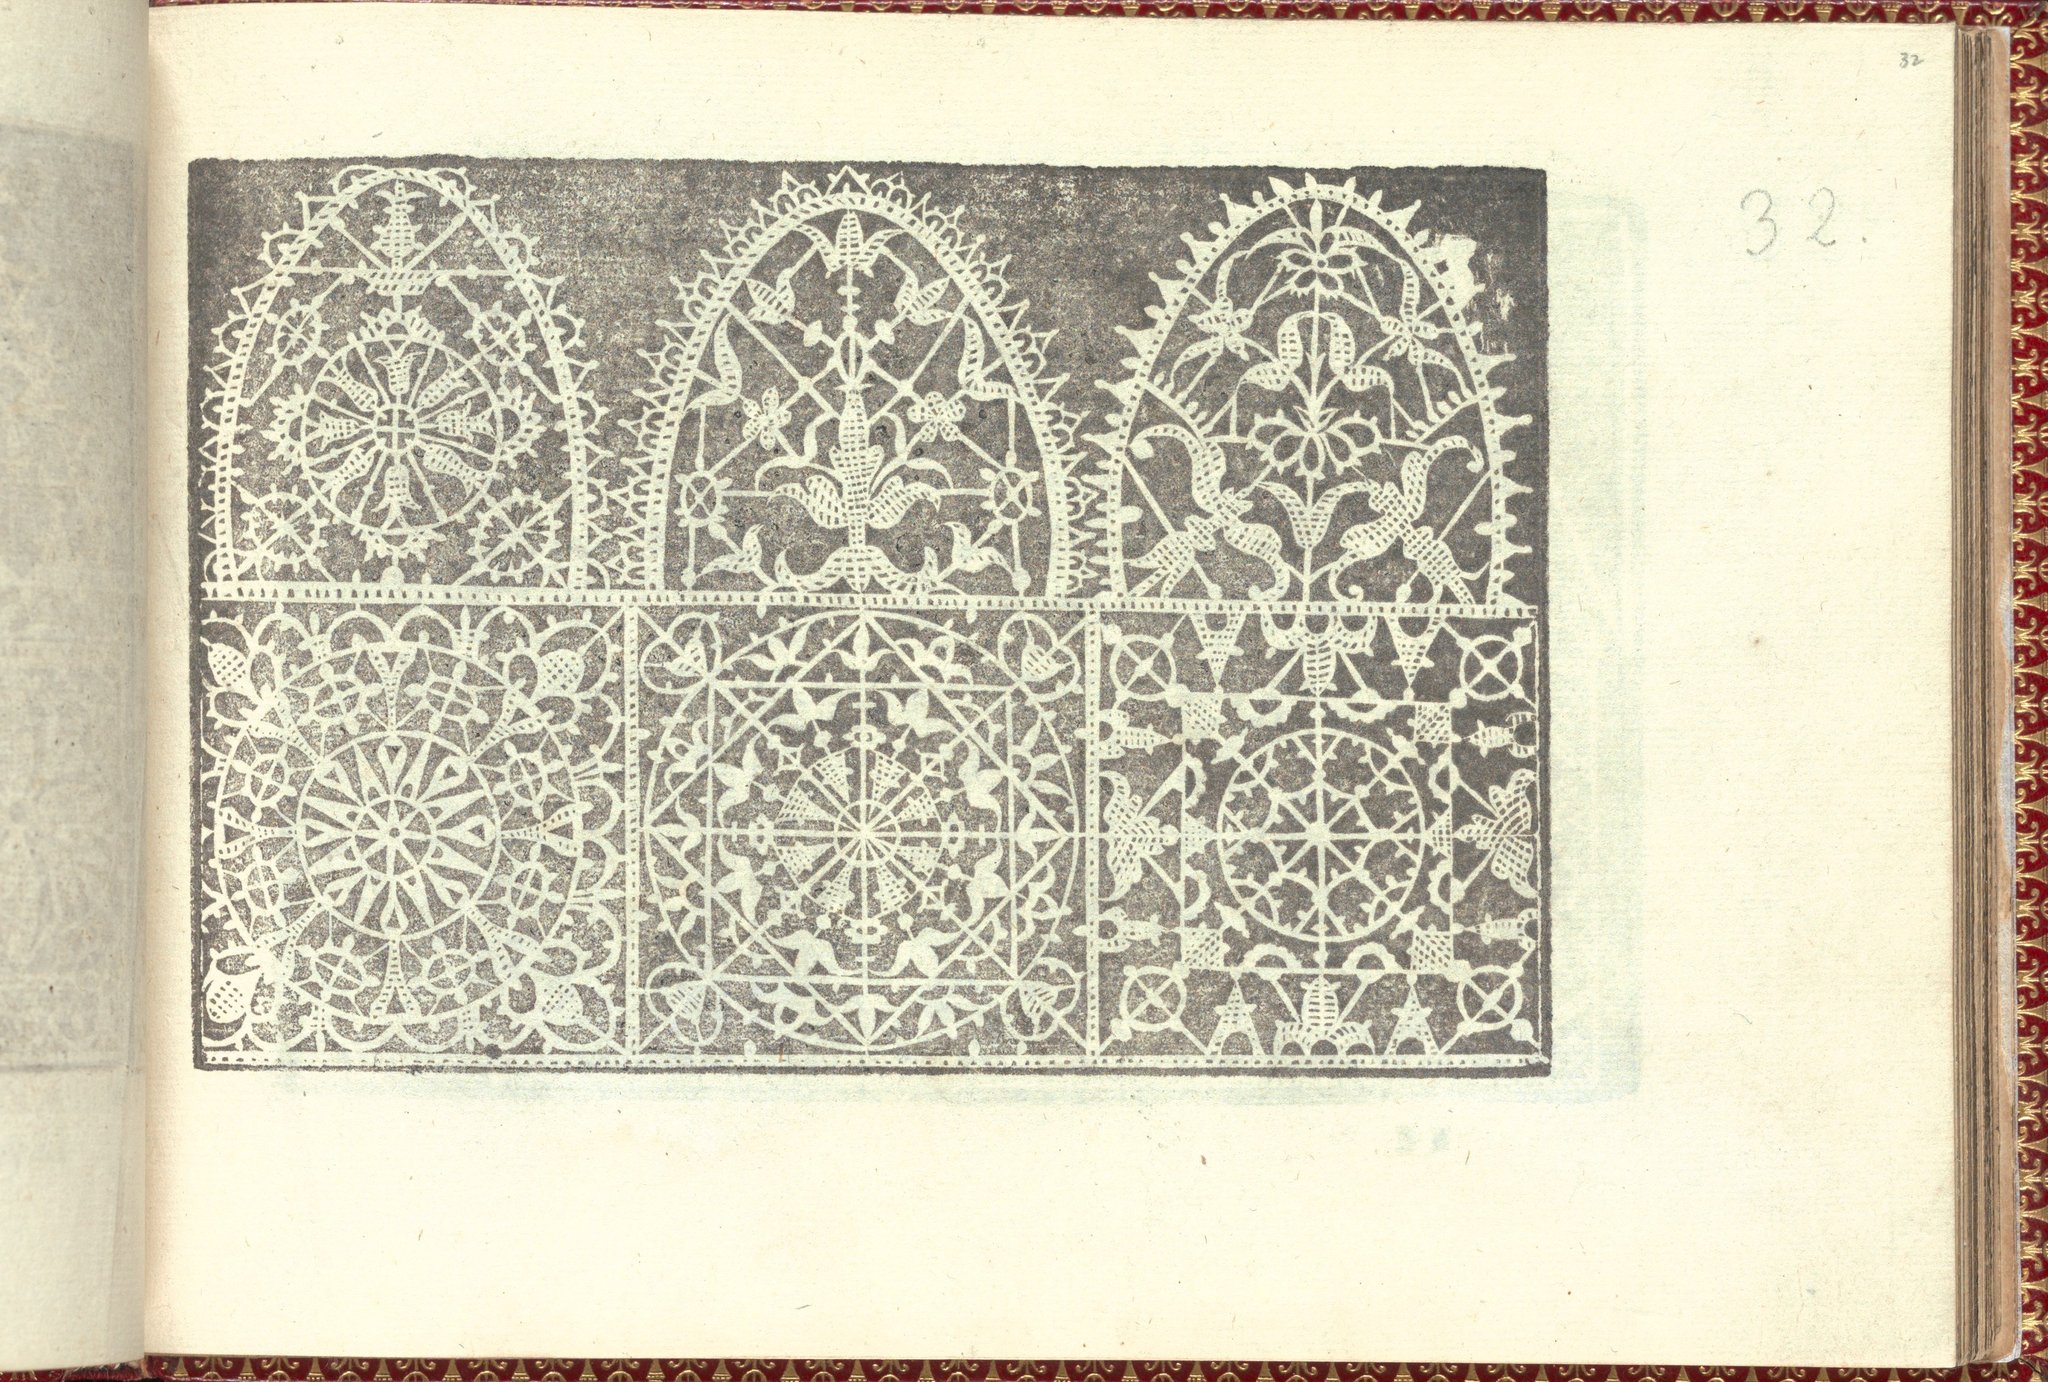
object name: book print ornament architecture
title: Corona delle Nobili et Virtuose Donne: Libro I-IV, page 32 (recto)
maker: cesare vecellio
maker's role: publisher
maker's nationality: italian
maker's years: 1521-1601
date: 1601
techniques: woodcut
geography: italy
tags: ornament